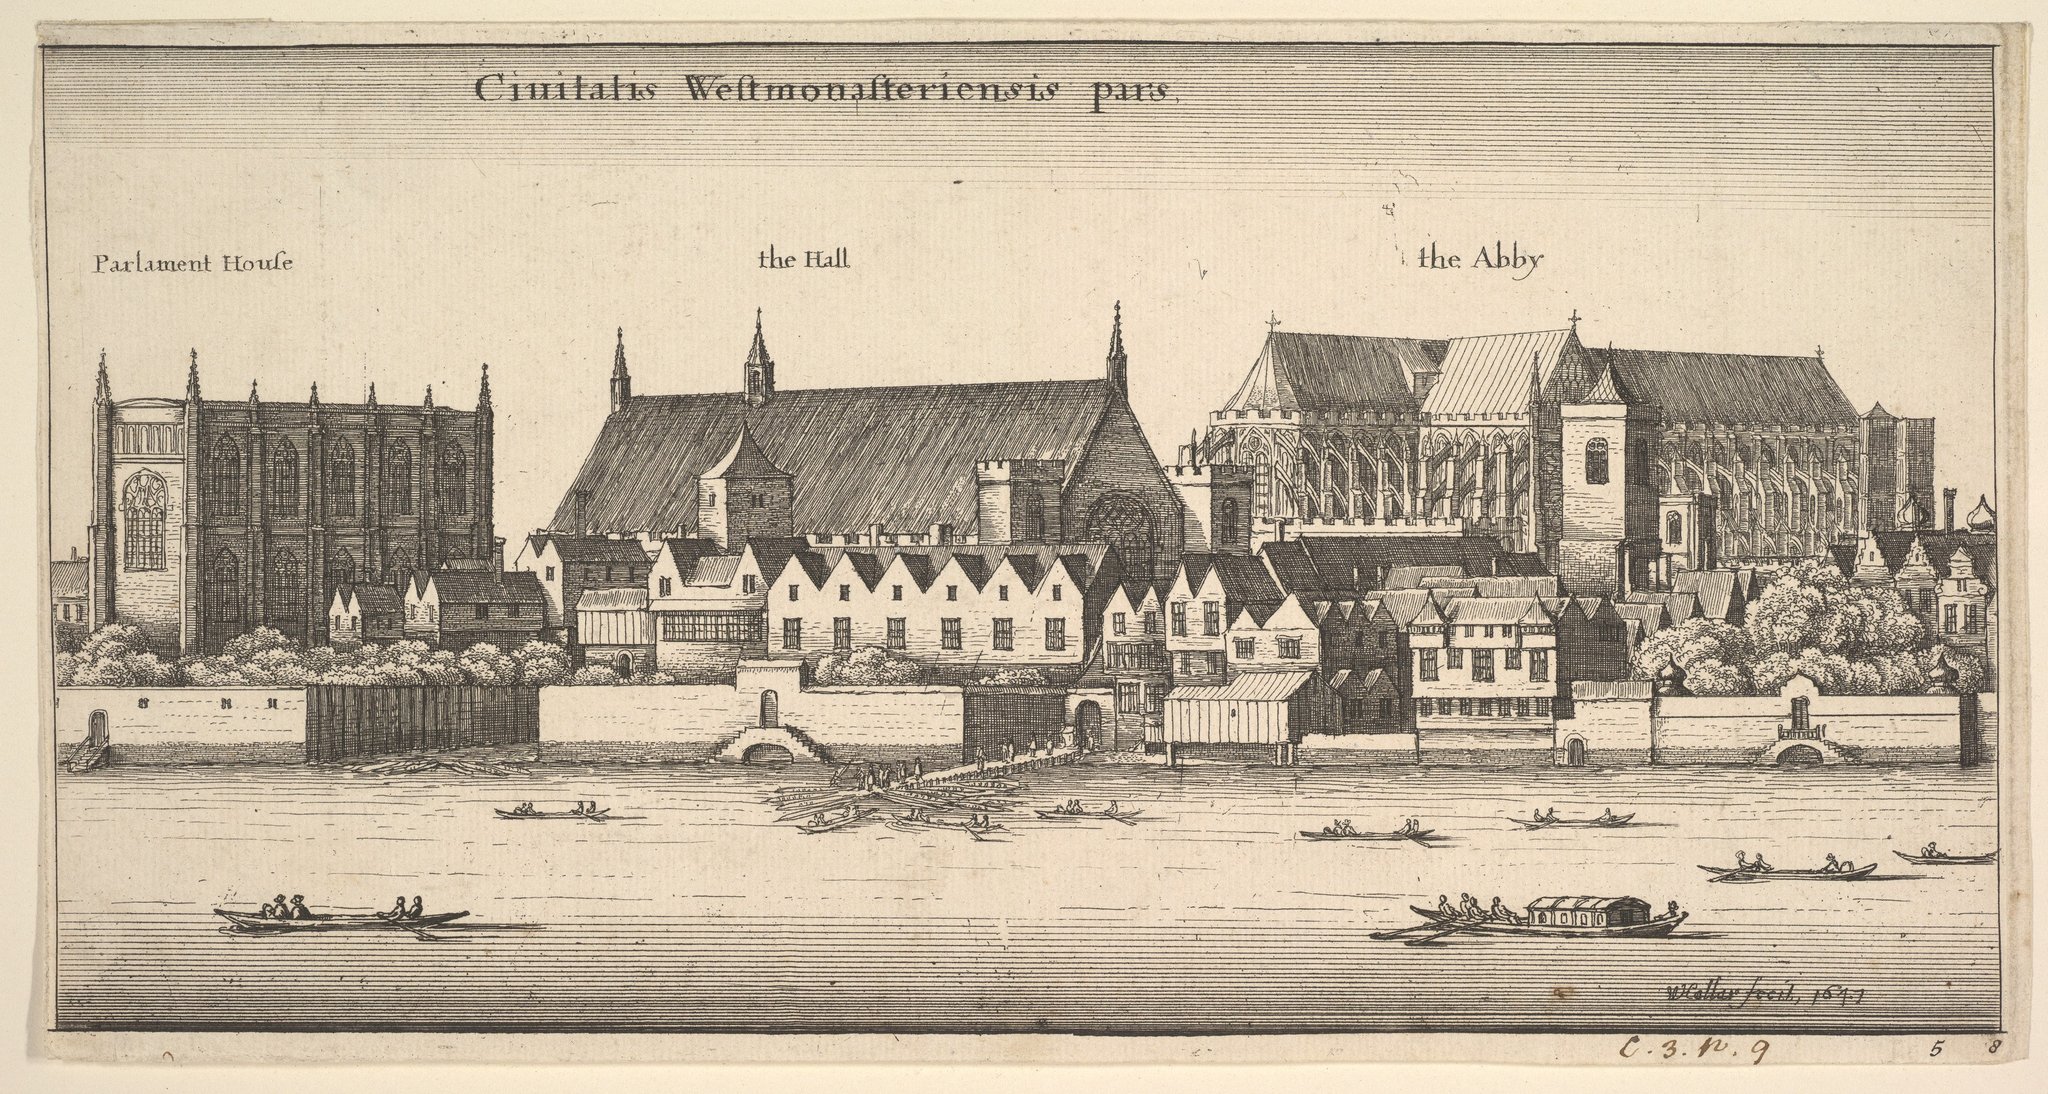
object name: print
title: Ciuitatis Westmonasteriensis pars (Westminster from the River)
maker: wenceslaus hollar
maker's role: artist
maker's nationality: bohemian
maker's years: 1607-1677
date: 1647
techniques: etching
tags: buildings,houses,rivers,boats